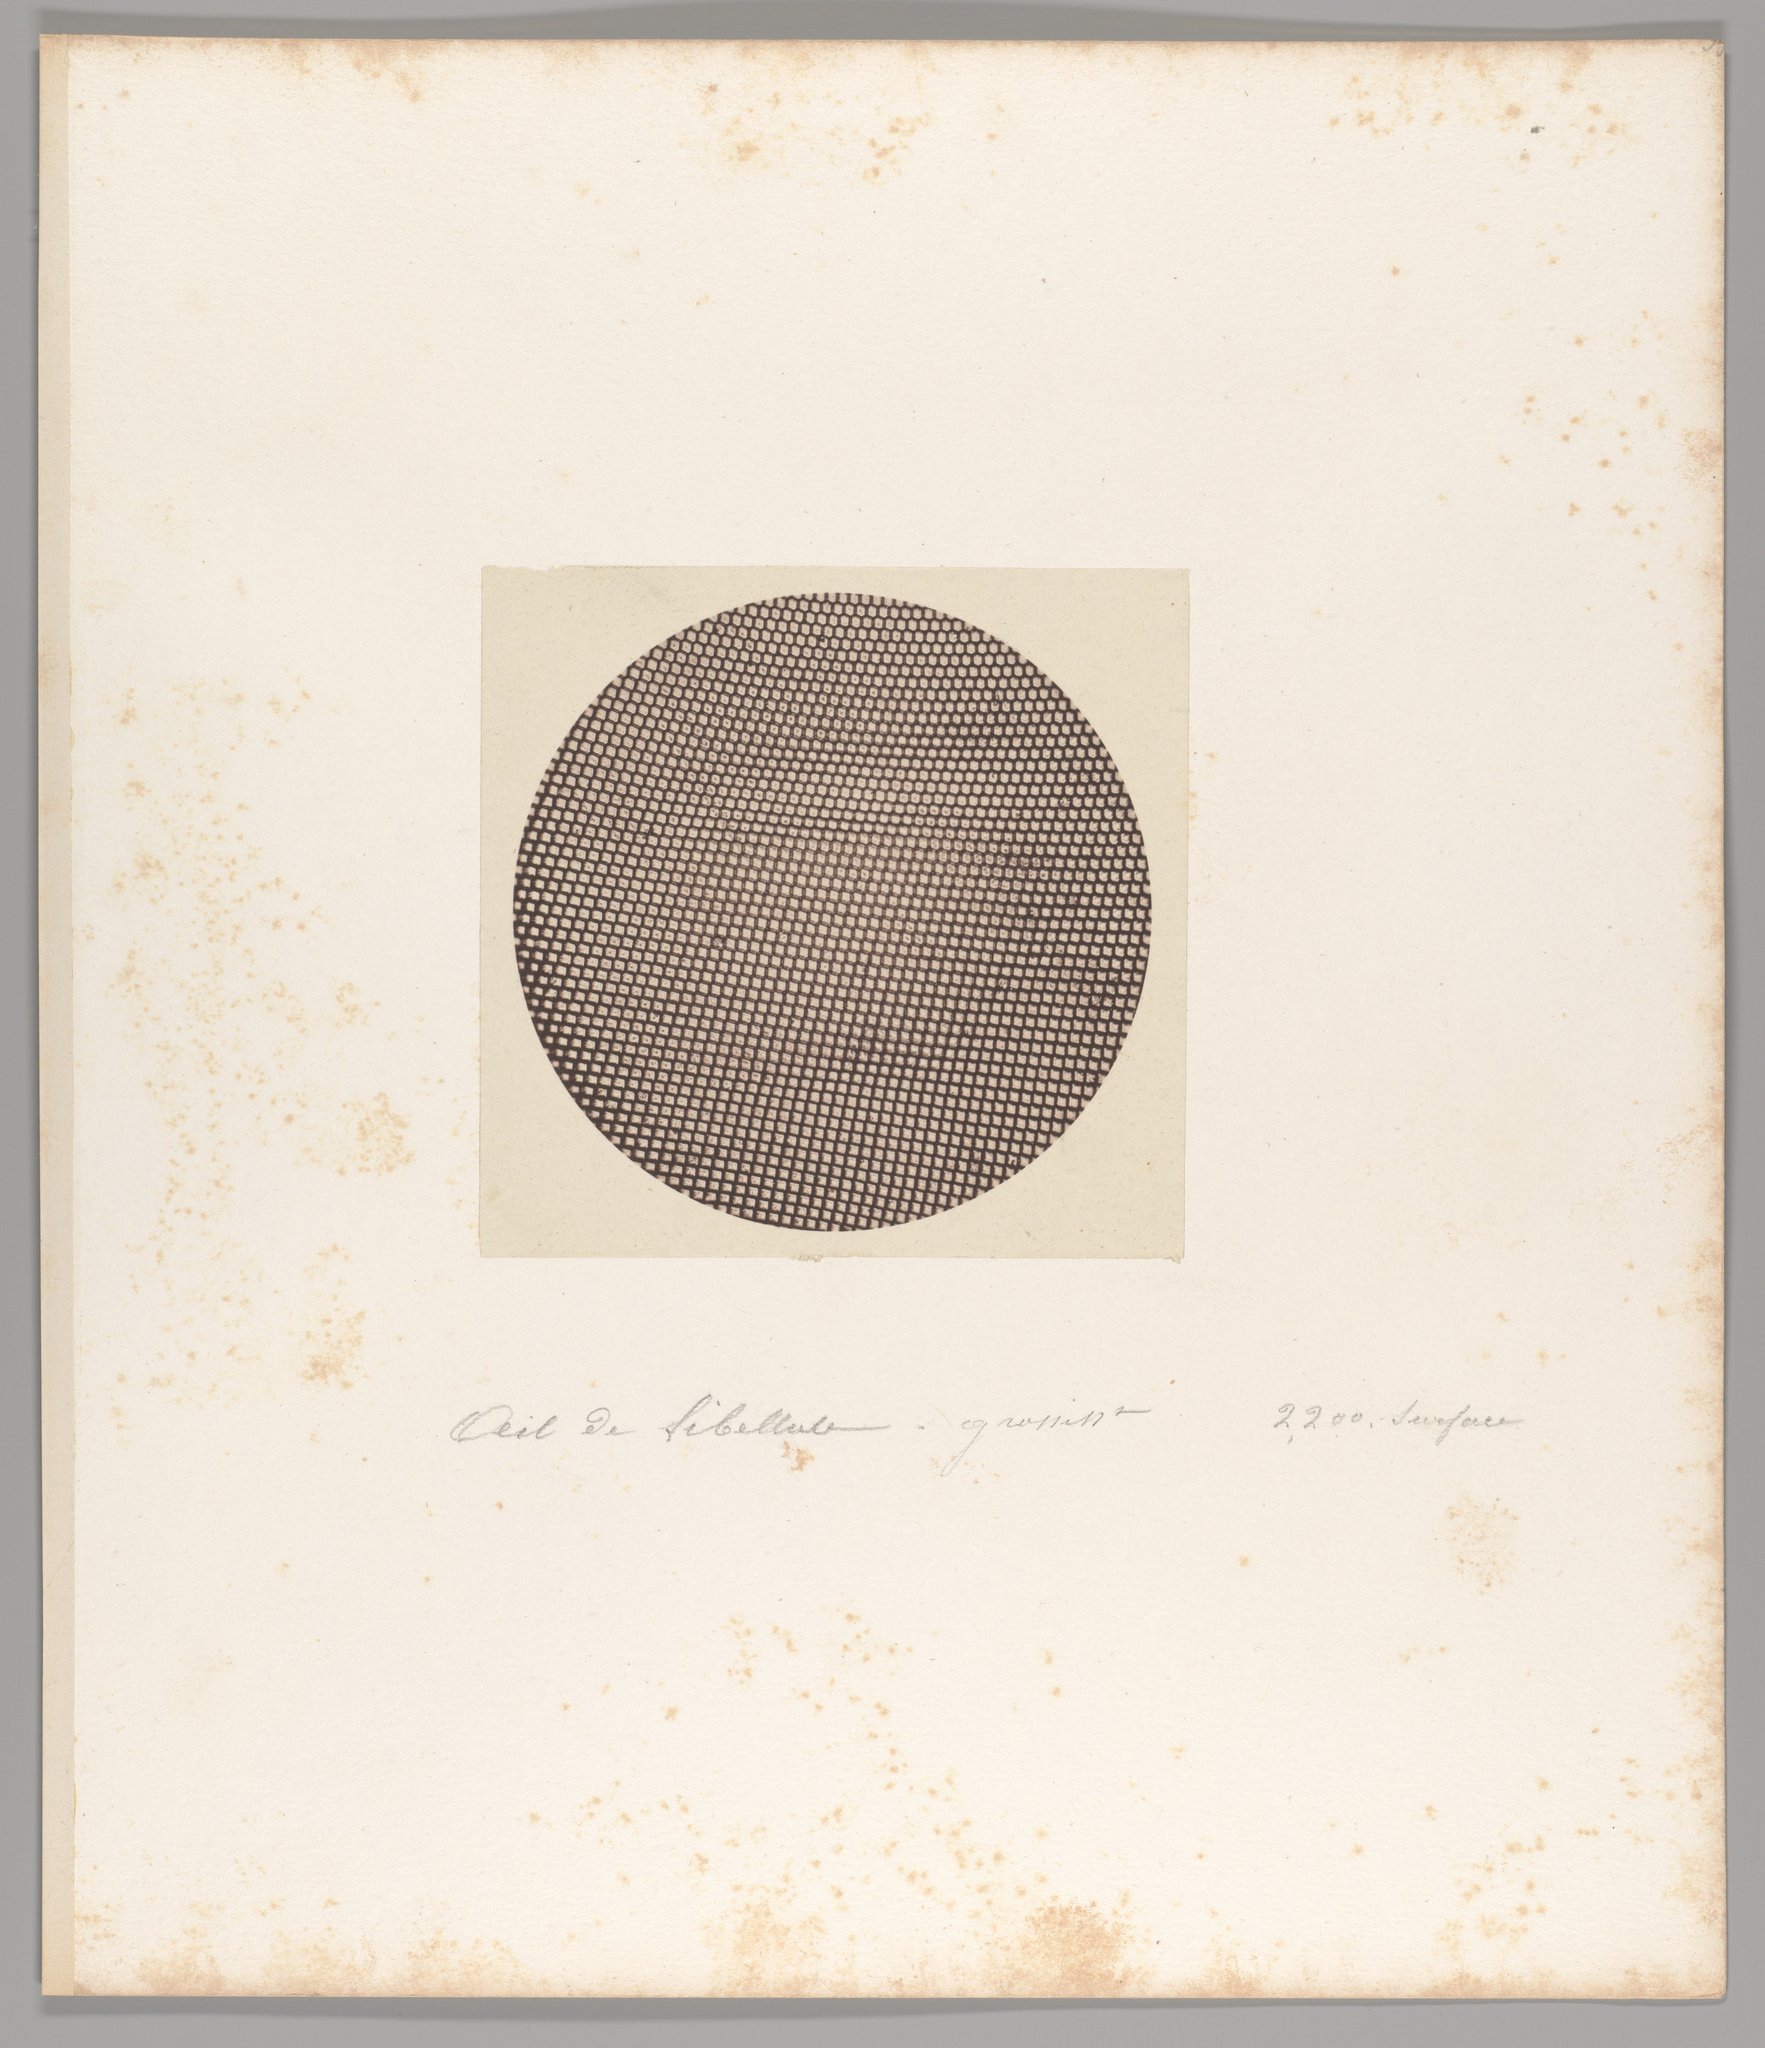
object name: photograph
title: Oeil du Libellule [Eye of a Dragonfly]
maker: auguste-adolphe bertsch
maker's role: artist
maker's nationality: french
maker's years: 1813-1871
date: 1853-1857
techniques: salted paper print